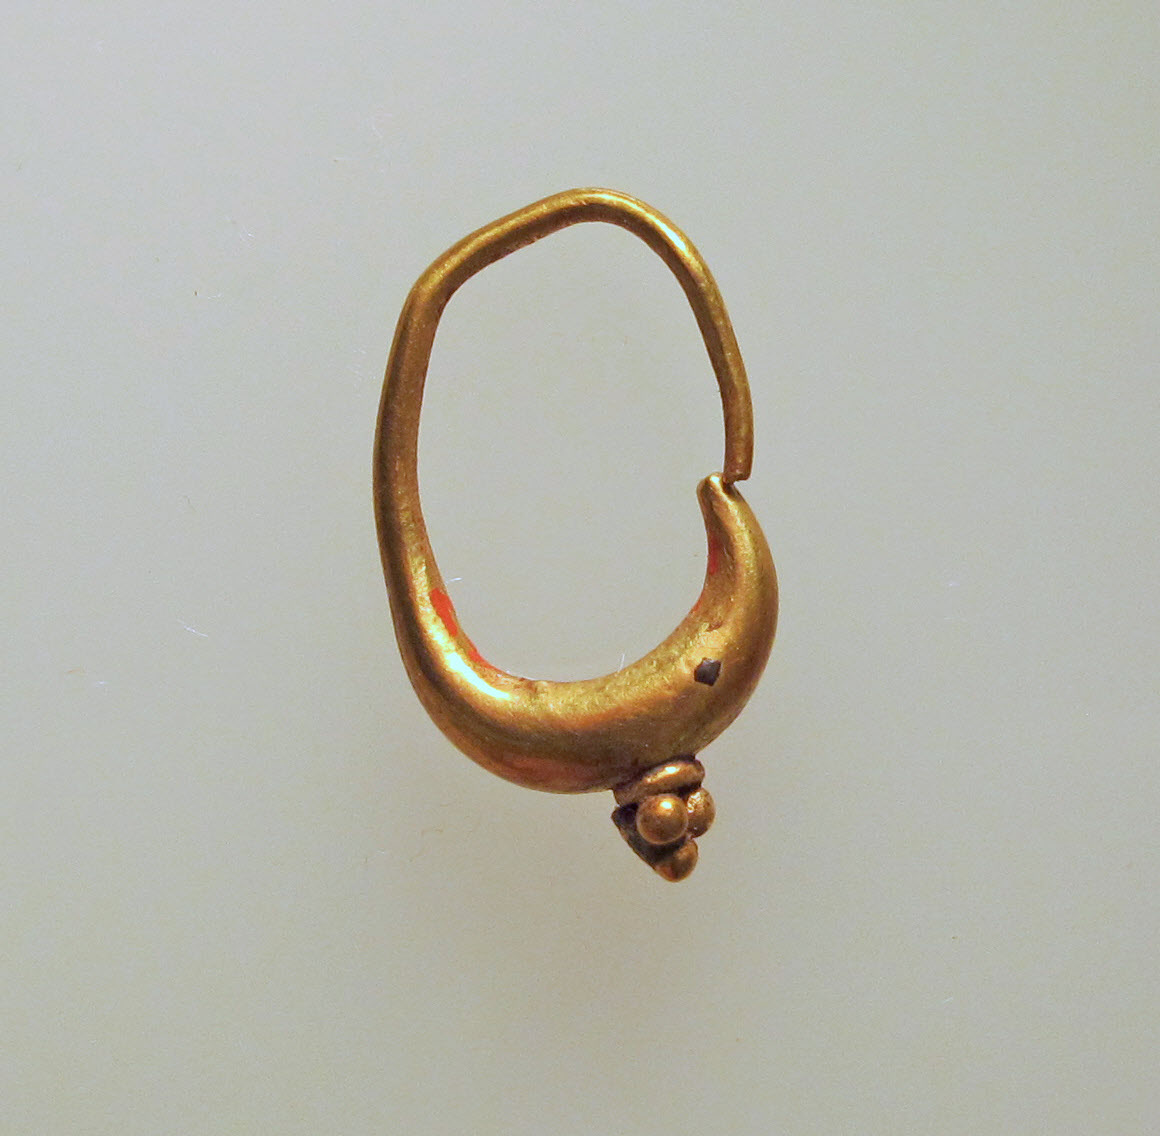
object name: earring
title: Earrings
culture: cypriot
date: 3900 BCE-100 CE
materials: gold